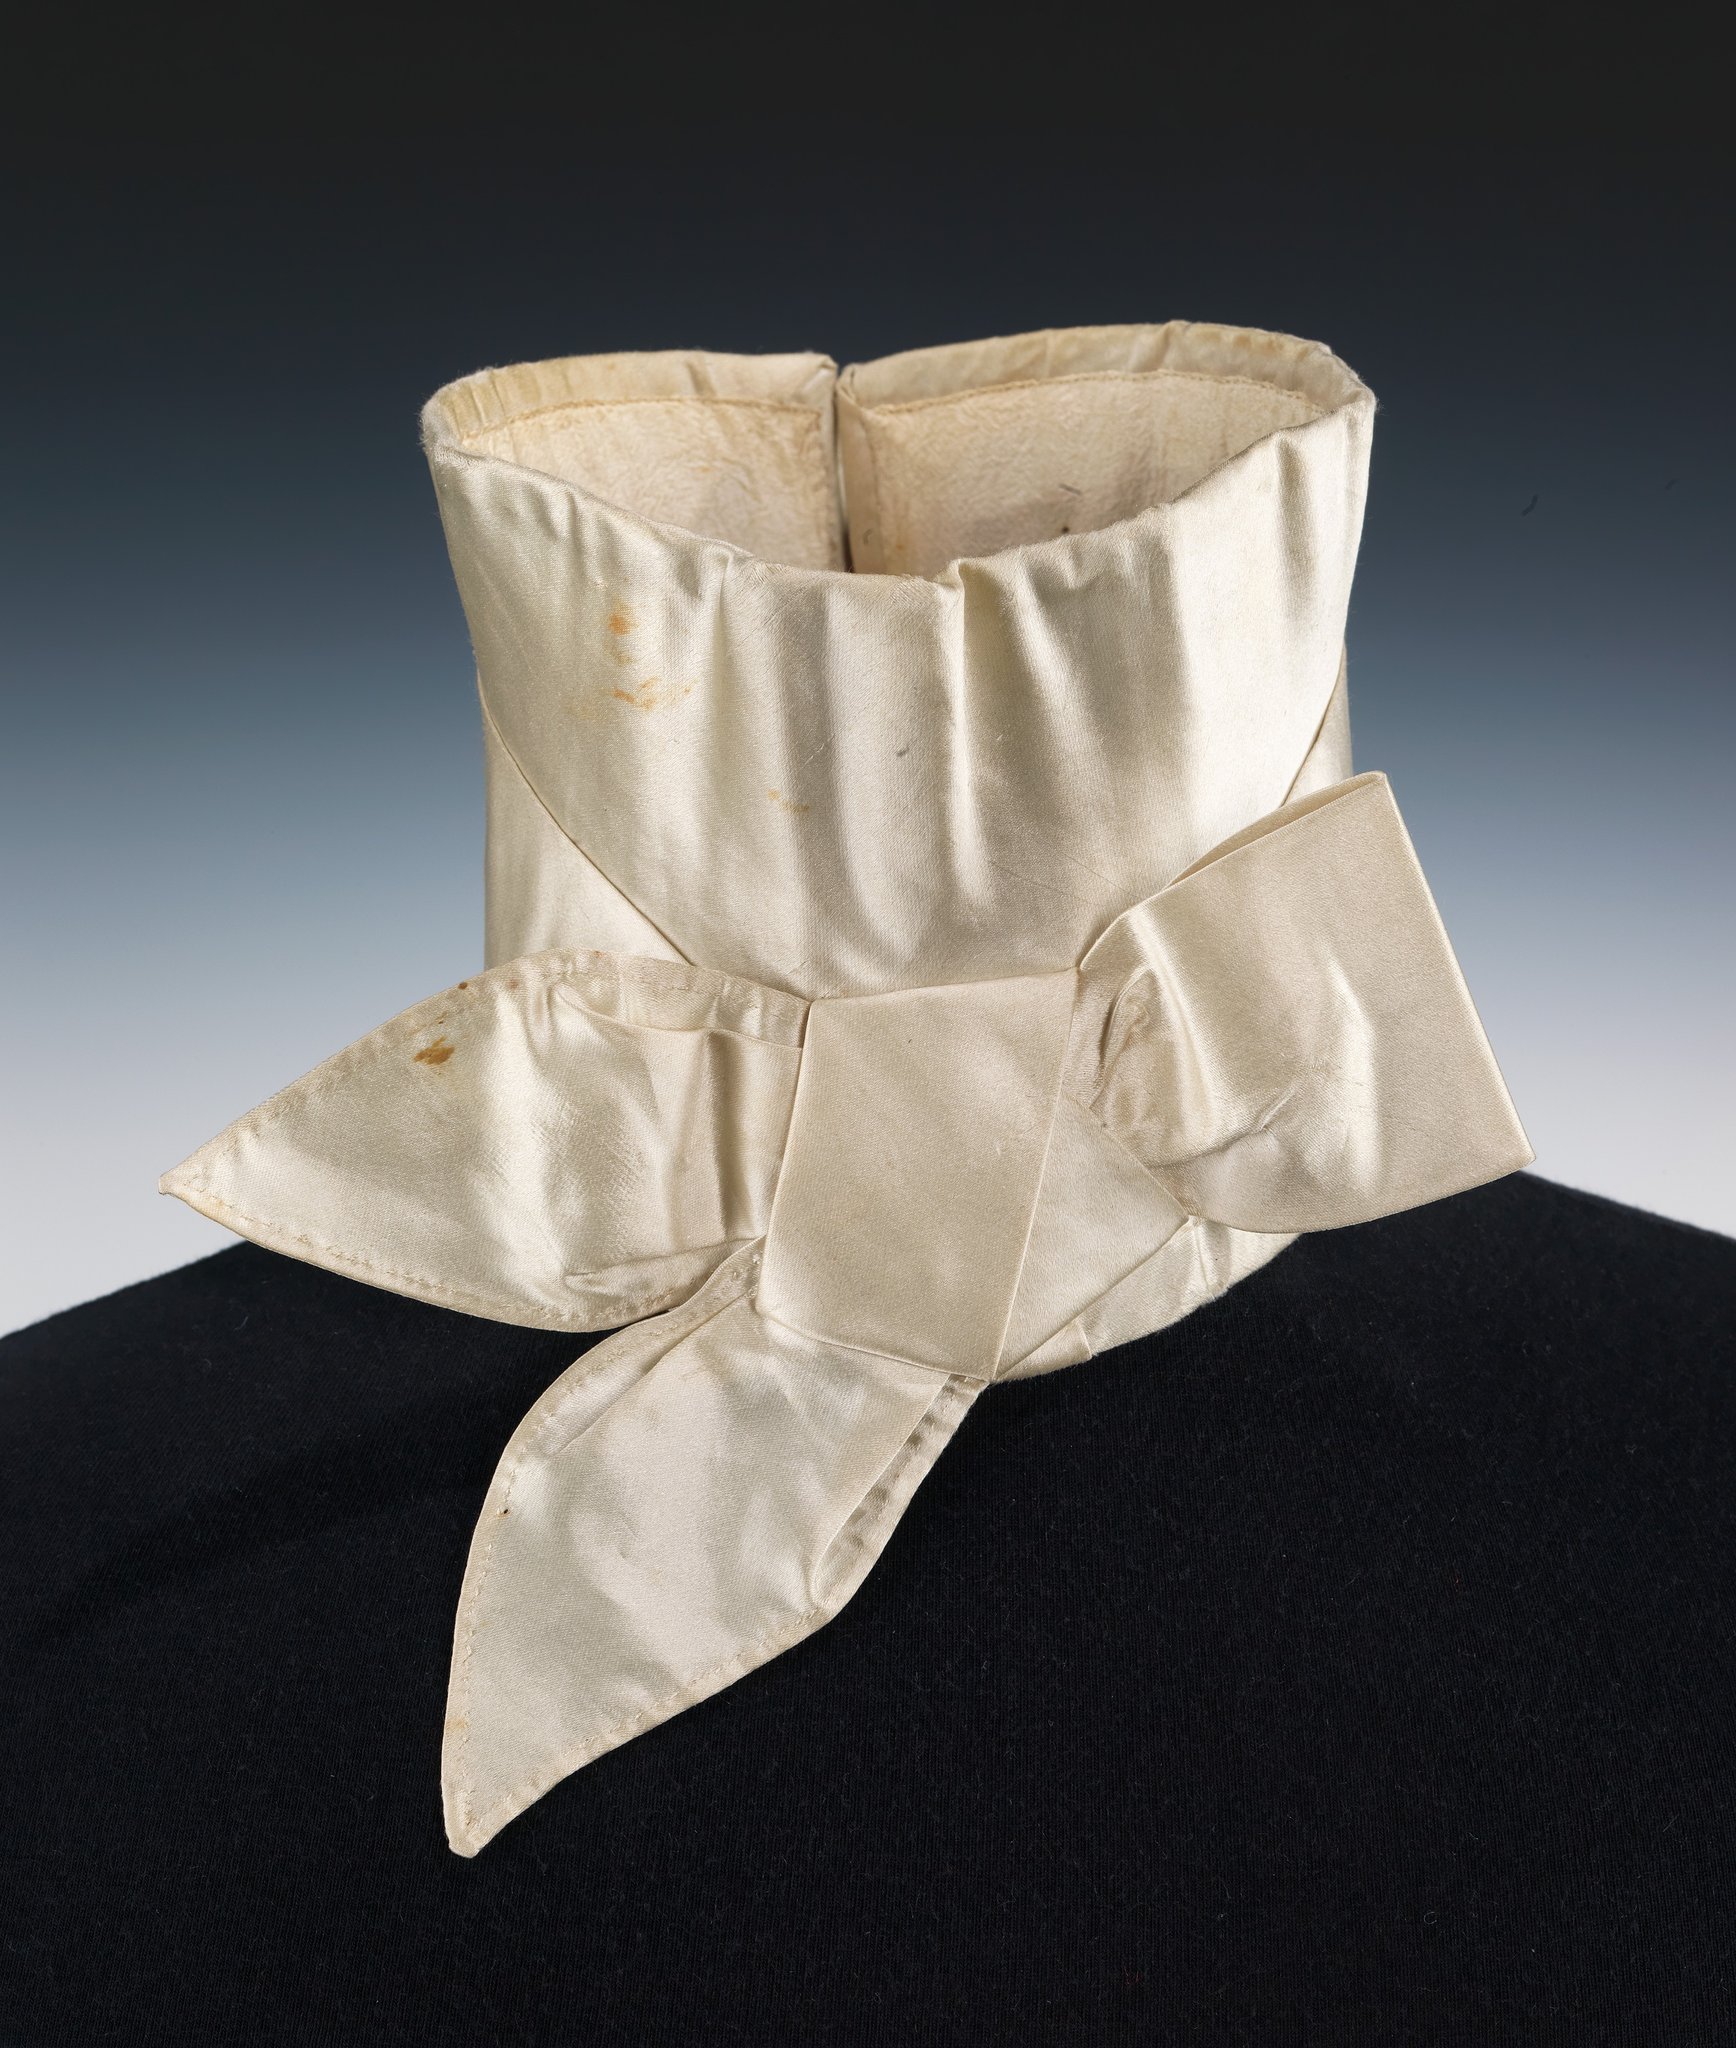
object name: wedding stock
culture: american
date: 1835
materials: metal, silk